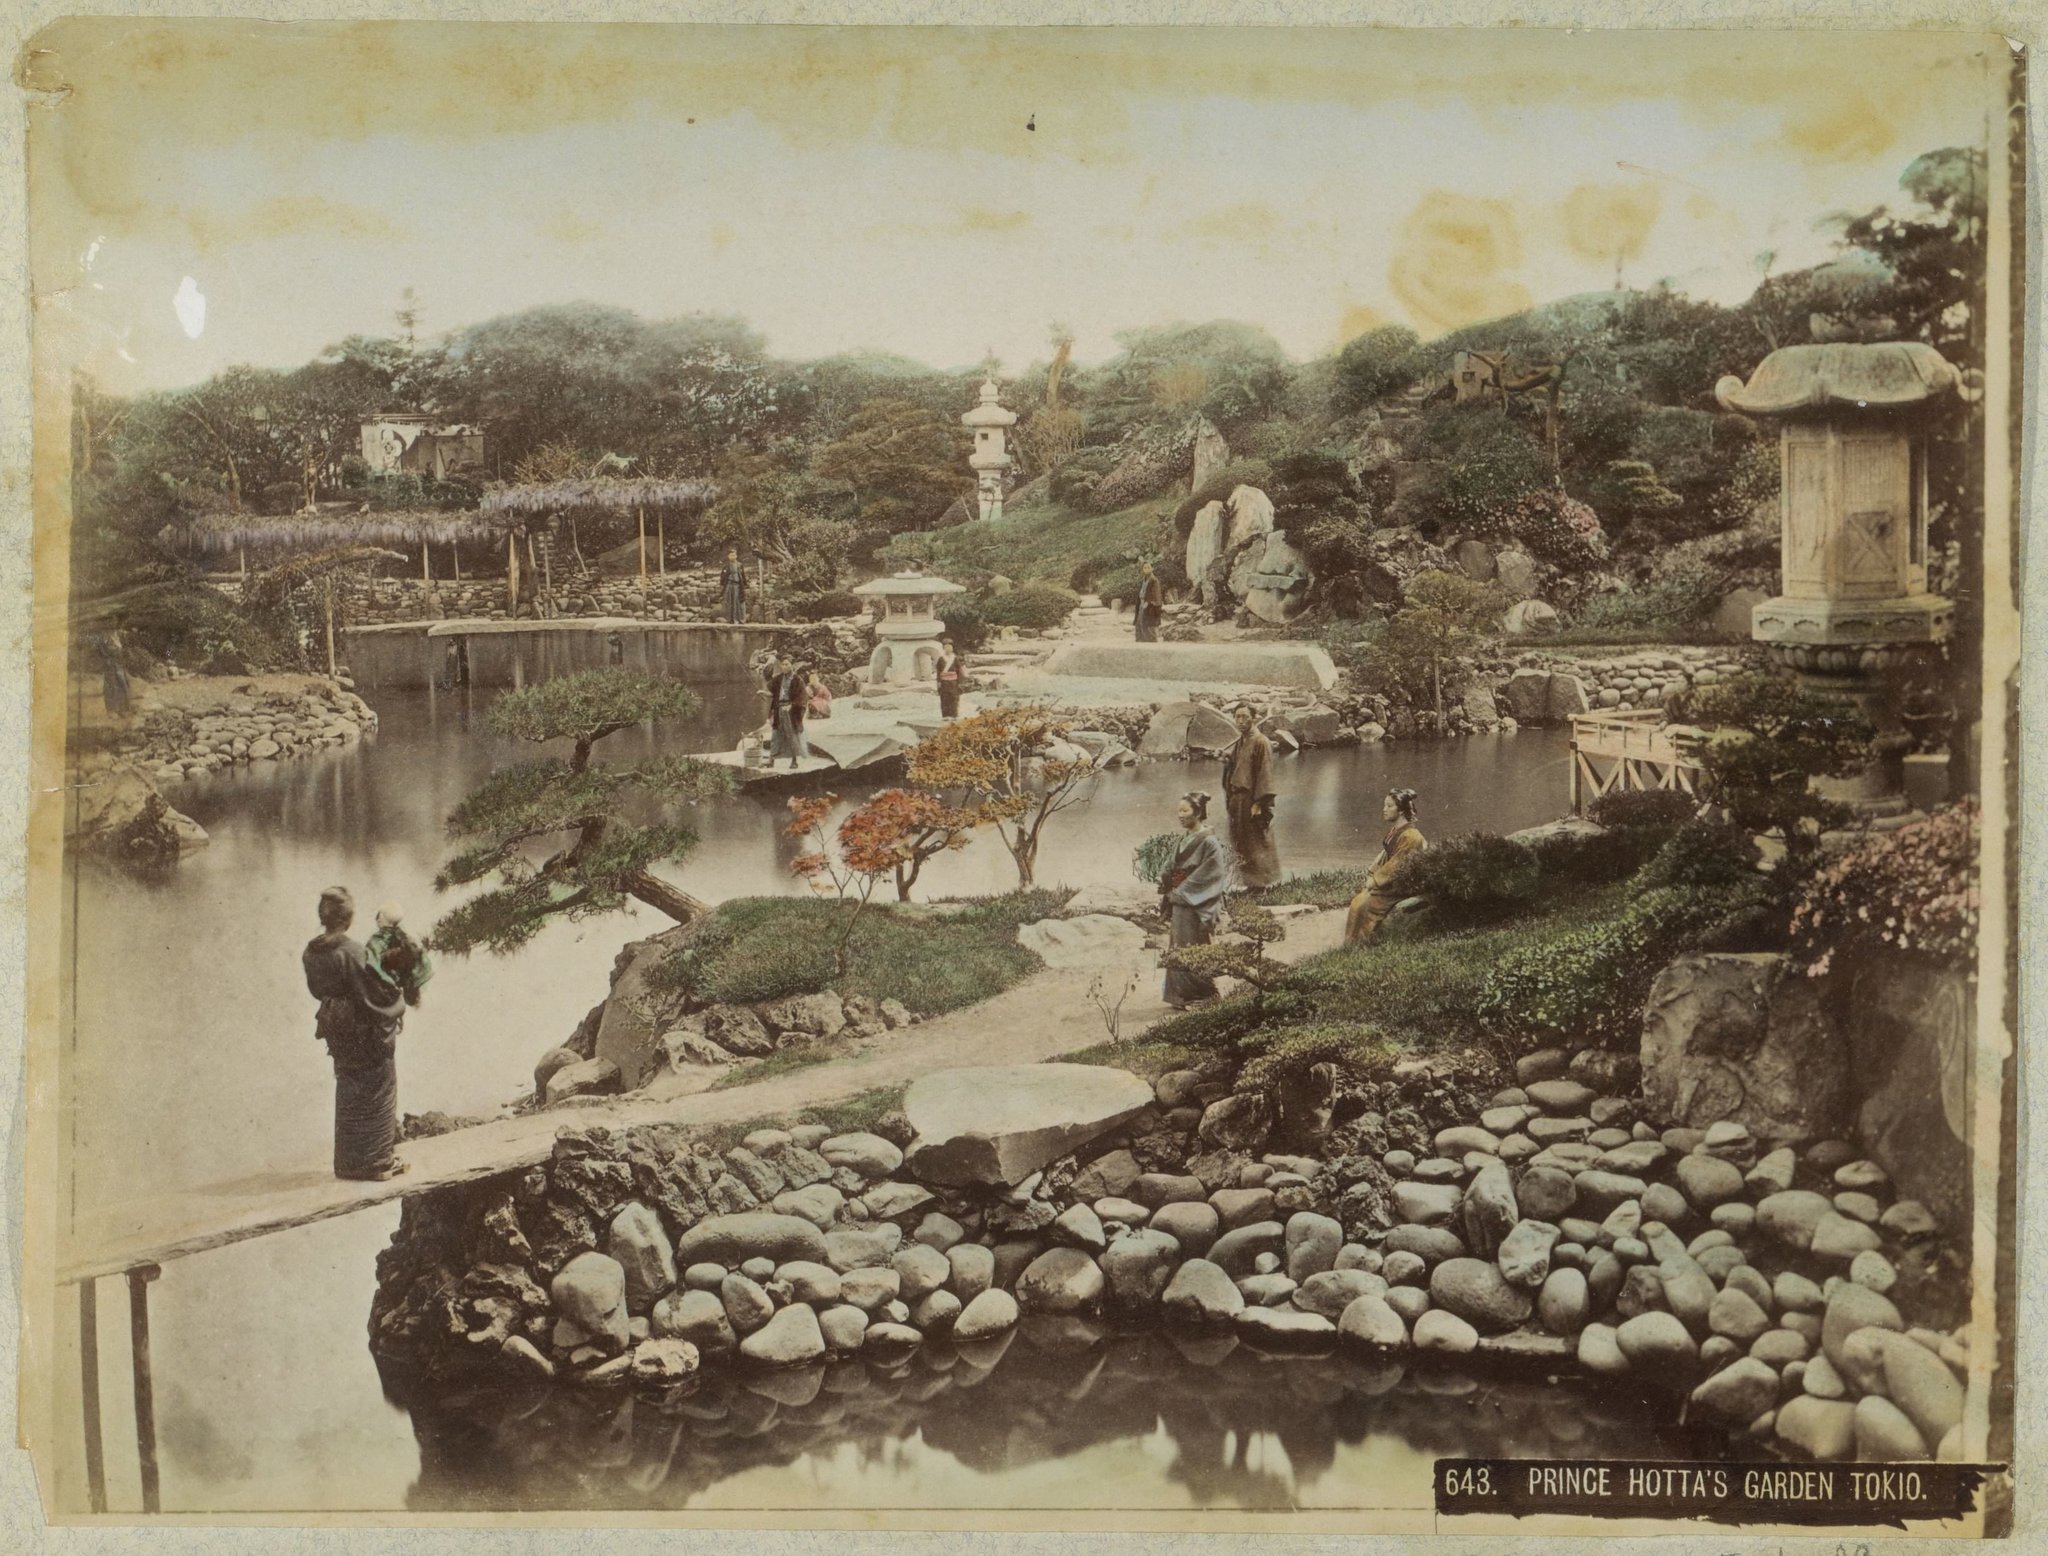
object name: photograph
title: Prins Hotta's tuin in Tokyo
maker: kusakabe kimbei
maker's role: fotograaf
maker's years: 1841-1934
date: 1870-1891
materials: paper, photographic support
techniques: albumen print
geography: tokyo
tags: public gardens, park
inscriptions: negative number: ‘643’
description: Onderdeel van Fotoalbum van een reis naar Manilla.